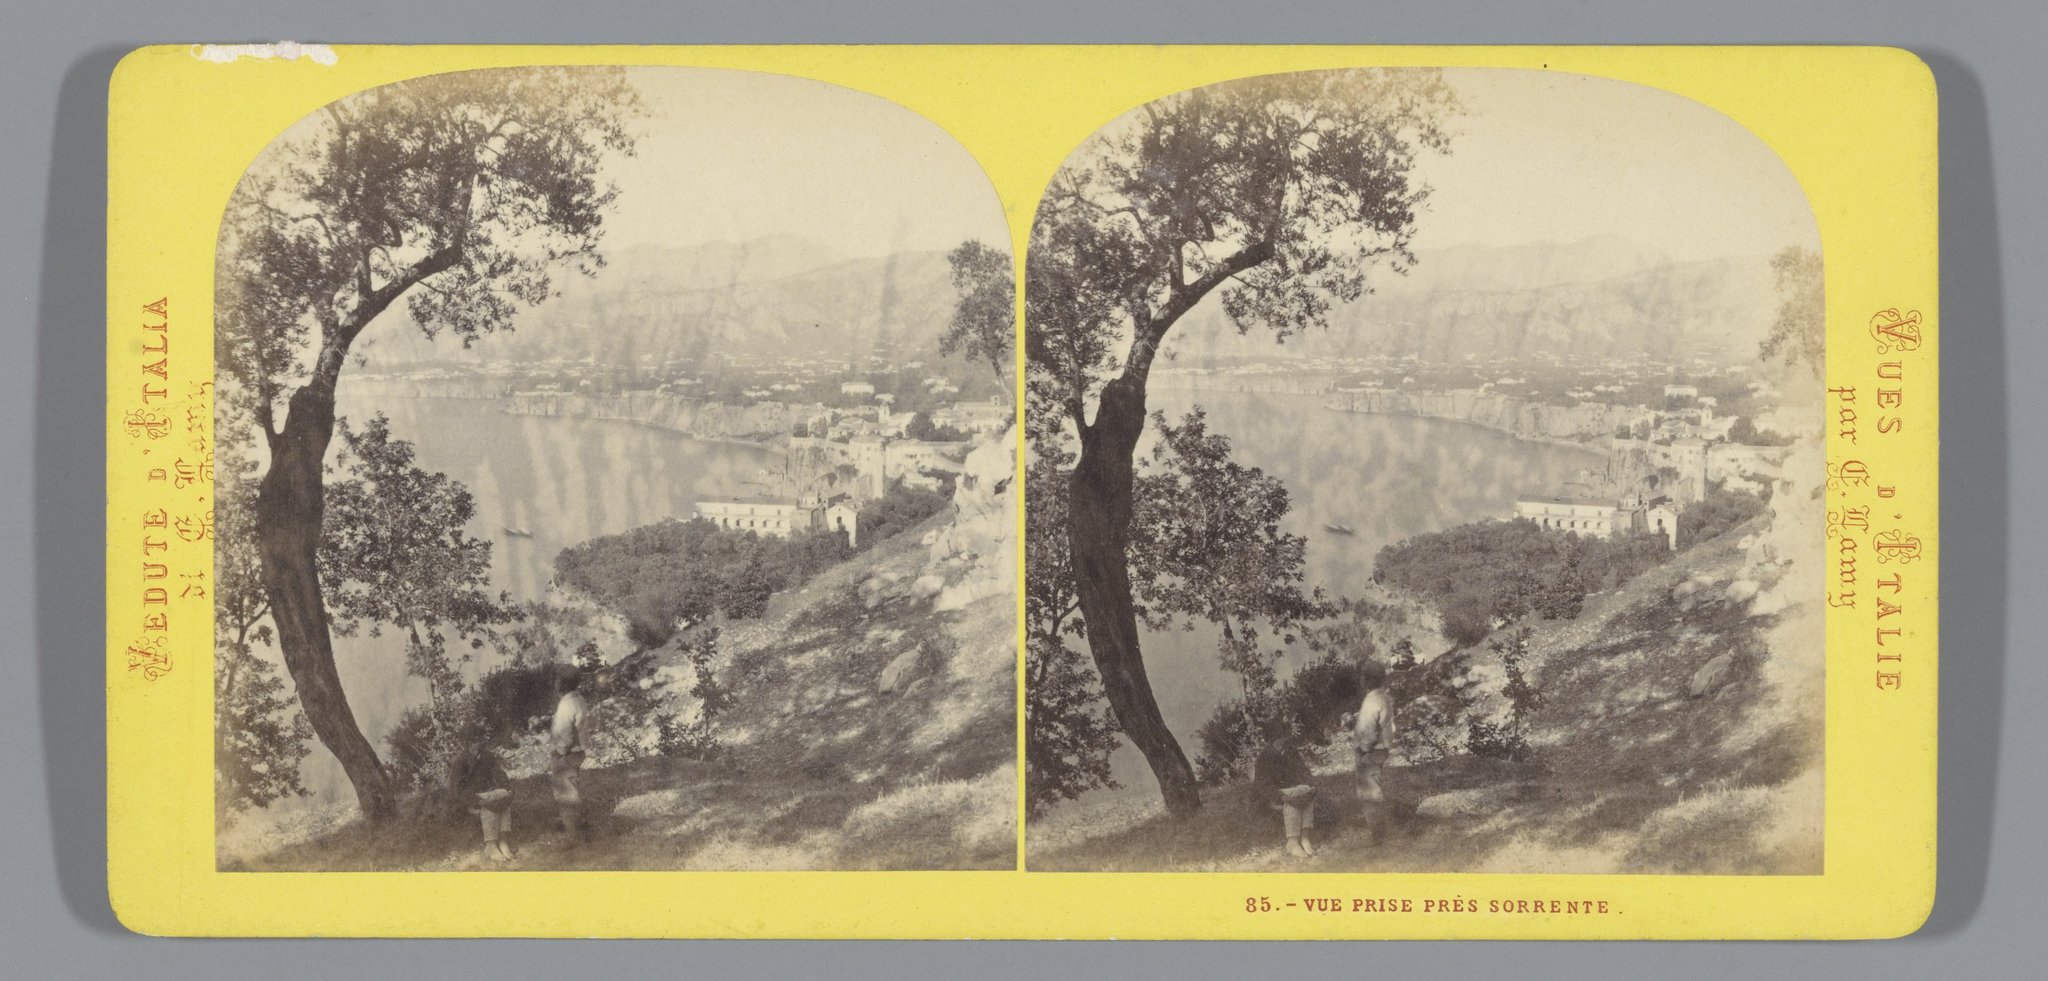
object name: stereograph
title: Vedute d'Italia / Vues d'Italie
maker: ernest eléonor pierre lamy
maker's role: publisher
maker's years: 1828-1900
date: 1861-1878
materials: cardboard, paper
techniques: albumen print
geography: sorrento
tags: gulf, bay, sorrento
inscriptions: number: ‘85.’